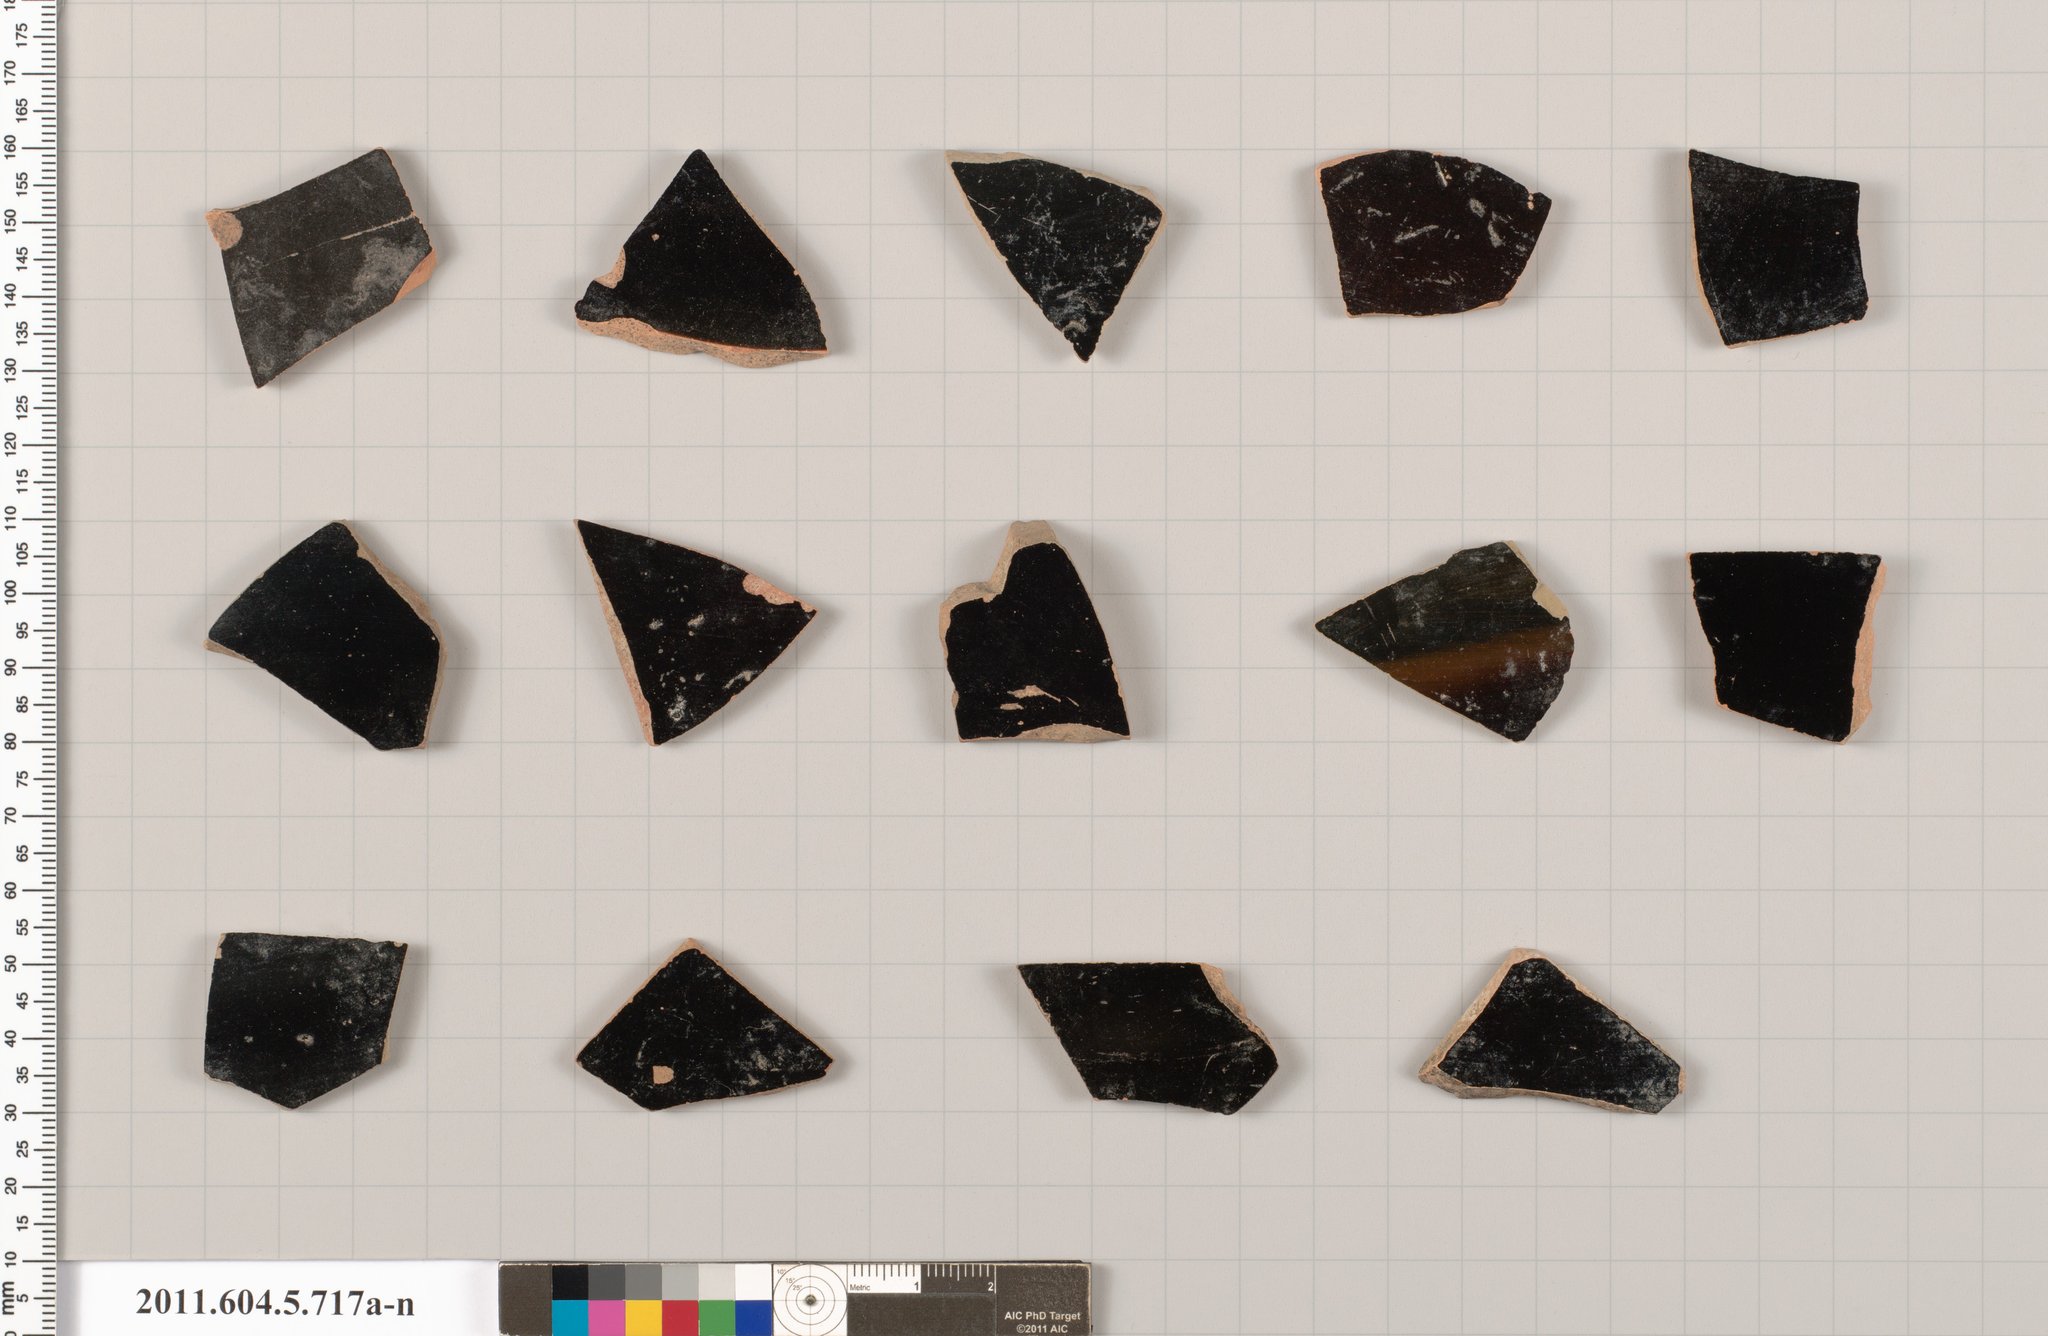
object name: kylix fragment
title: Terracotta fragments of kylikes (drinking cups)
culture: greek, attic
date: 600-401 BCE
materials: terracotta